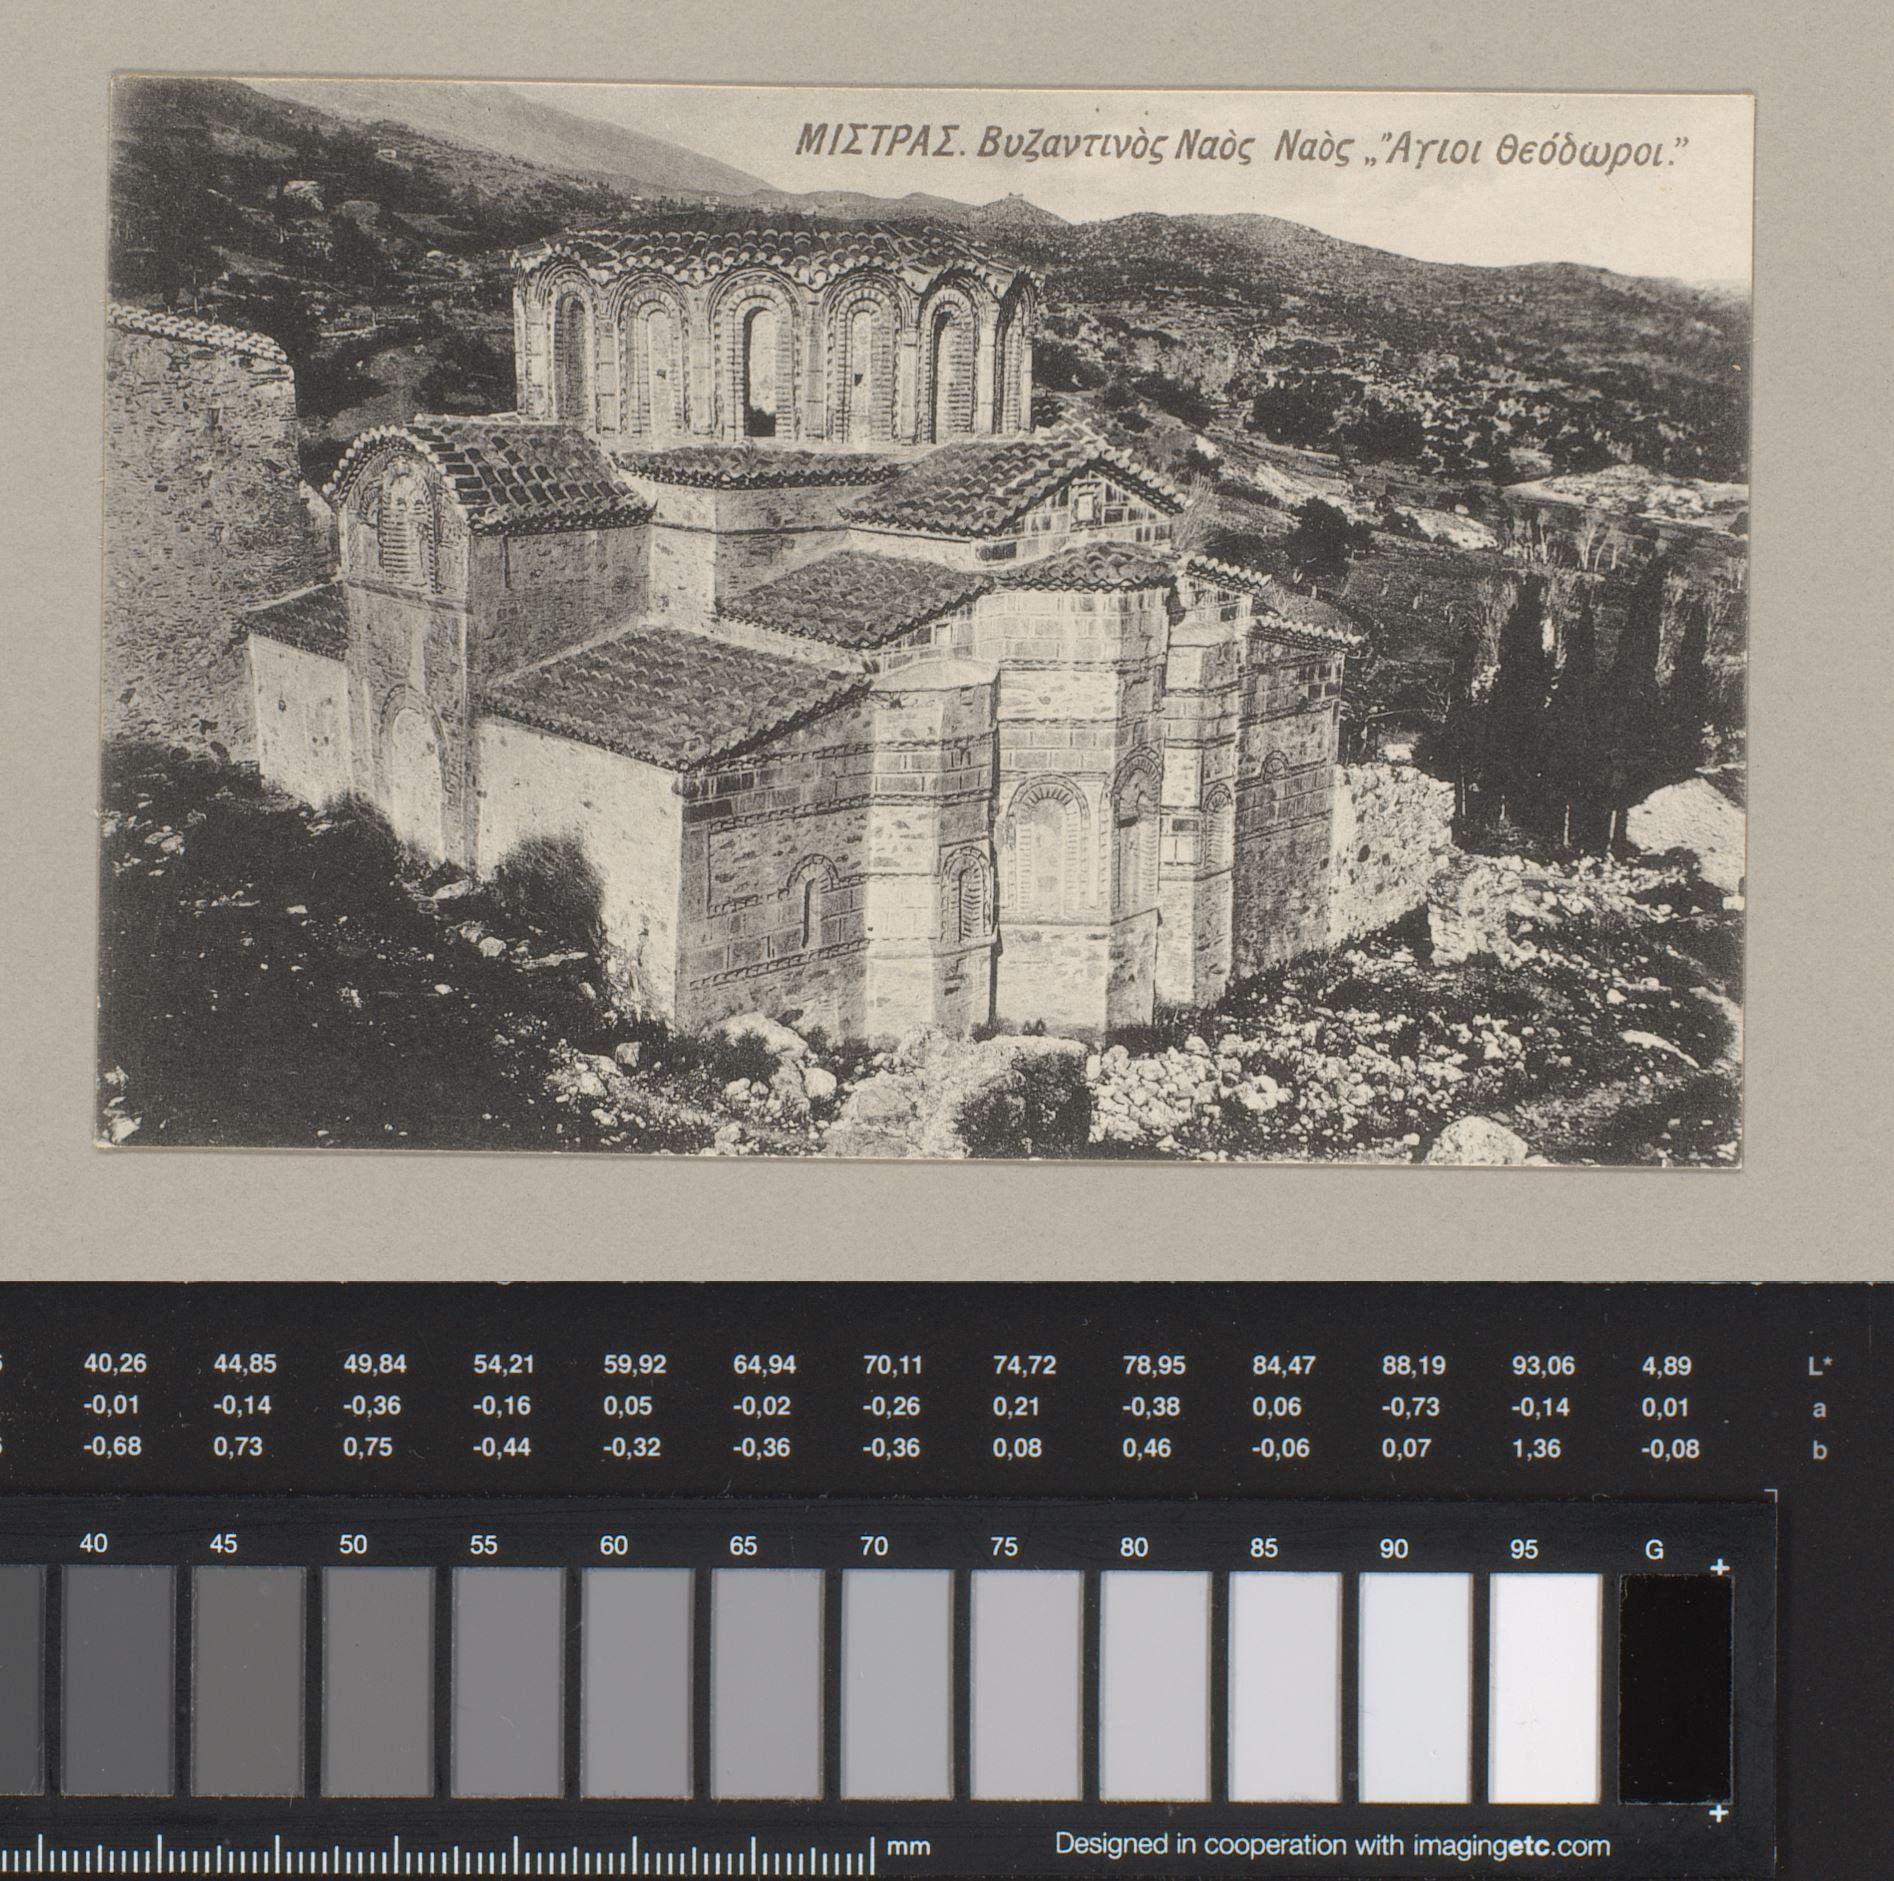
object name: photograph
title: Kerk van de Heilige Theodor te Mistra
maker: Anonymous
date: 1895-1915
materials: cardboard, paper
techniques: photograph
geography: peloponnese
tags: pelopónnesos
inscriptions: annotation: ‘5. Verwoeste Byzantijnsche Stad, Mistra.’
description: Rechtsboven staat een titel in het Grieks (?).